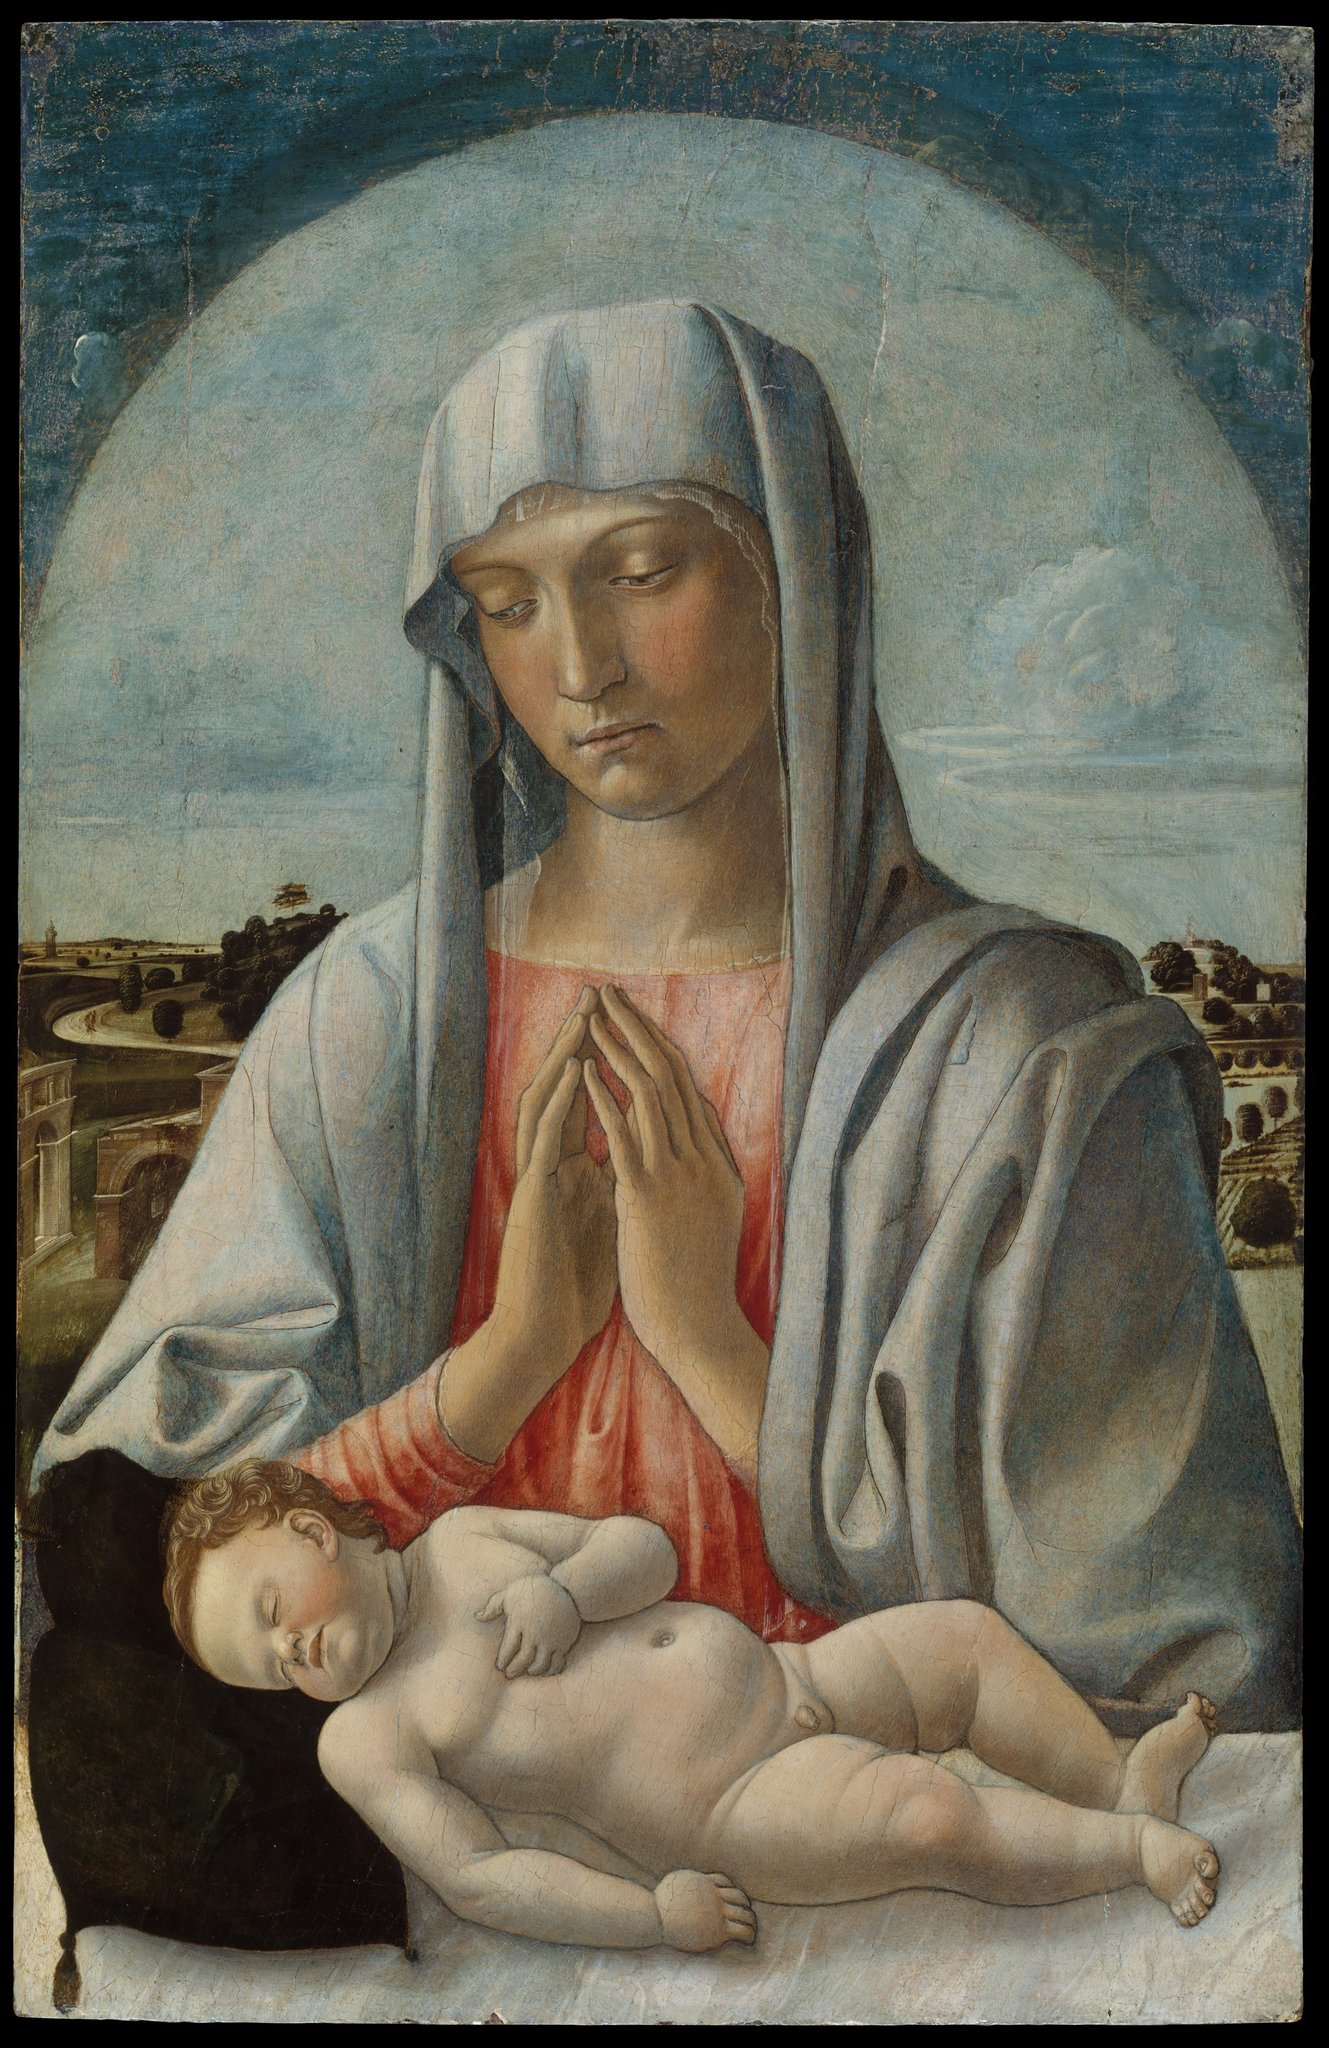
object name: painting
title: Madonna Adoring the Sleeping Child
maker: giovanni bellini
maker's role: artist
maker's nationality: italian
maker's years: 1424-1516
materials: paint, wood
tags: sleeping,madonna and child